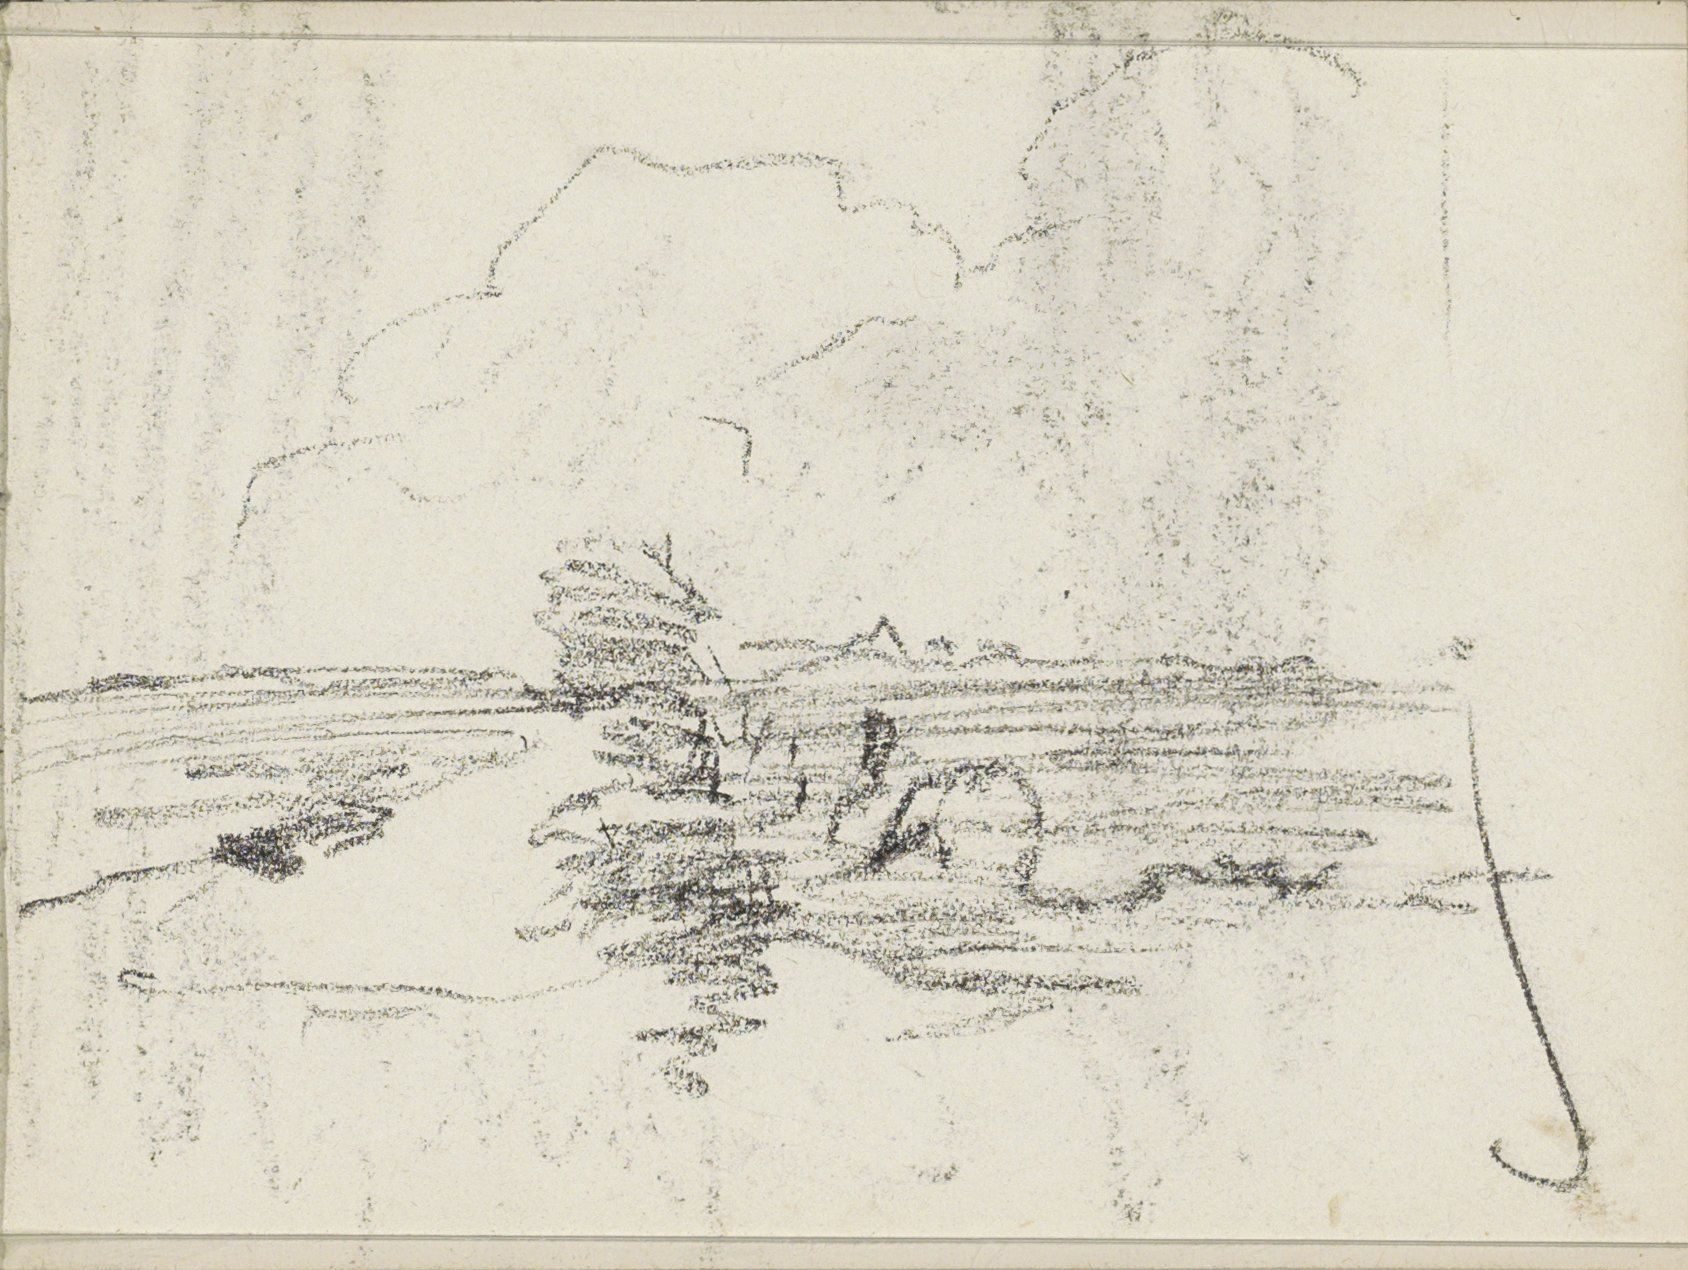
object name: sketchbook leaf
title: Landschap met water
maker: anton mauve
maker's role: draughtsman, painter, print maker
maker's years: 1838-1888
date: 1881-1888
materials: chalk, paper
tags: landscapes with waters, waterscapes, seascapes (in the temperate zone)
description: Blad 11 recto uit een schetsboek met 29 bladen.